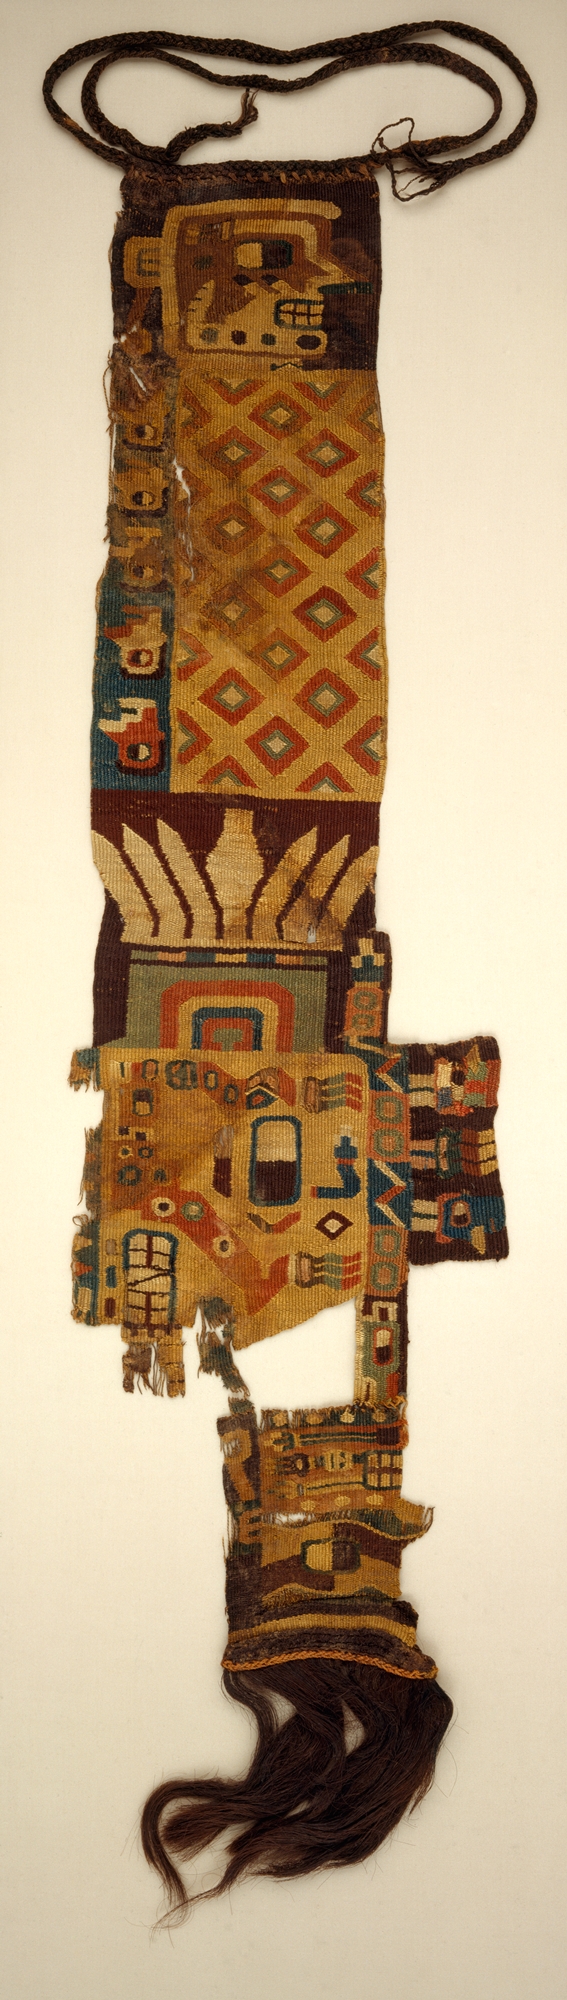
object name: emblem or sash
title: Neck Emblem or Sash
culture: pukara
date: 200 BCE-200 CE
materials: animal fiber, hair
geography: peru